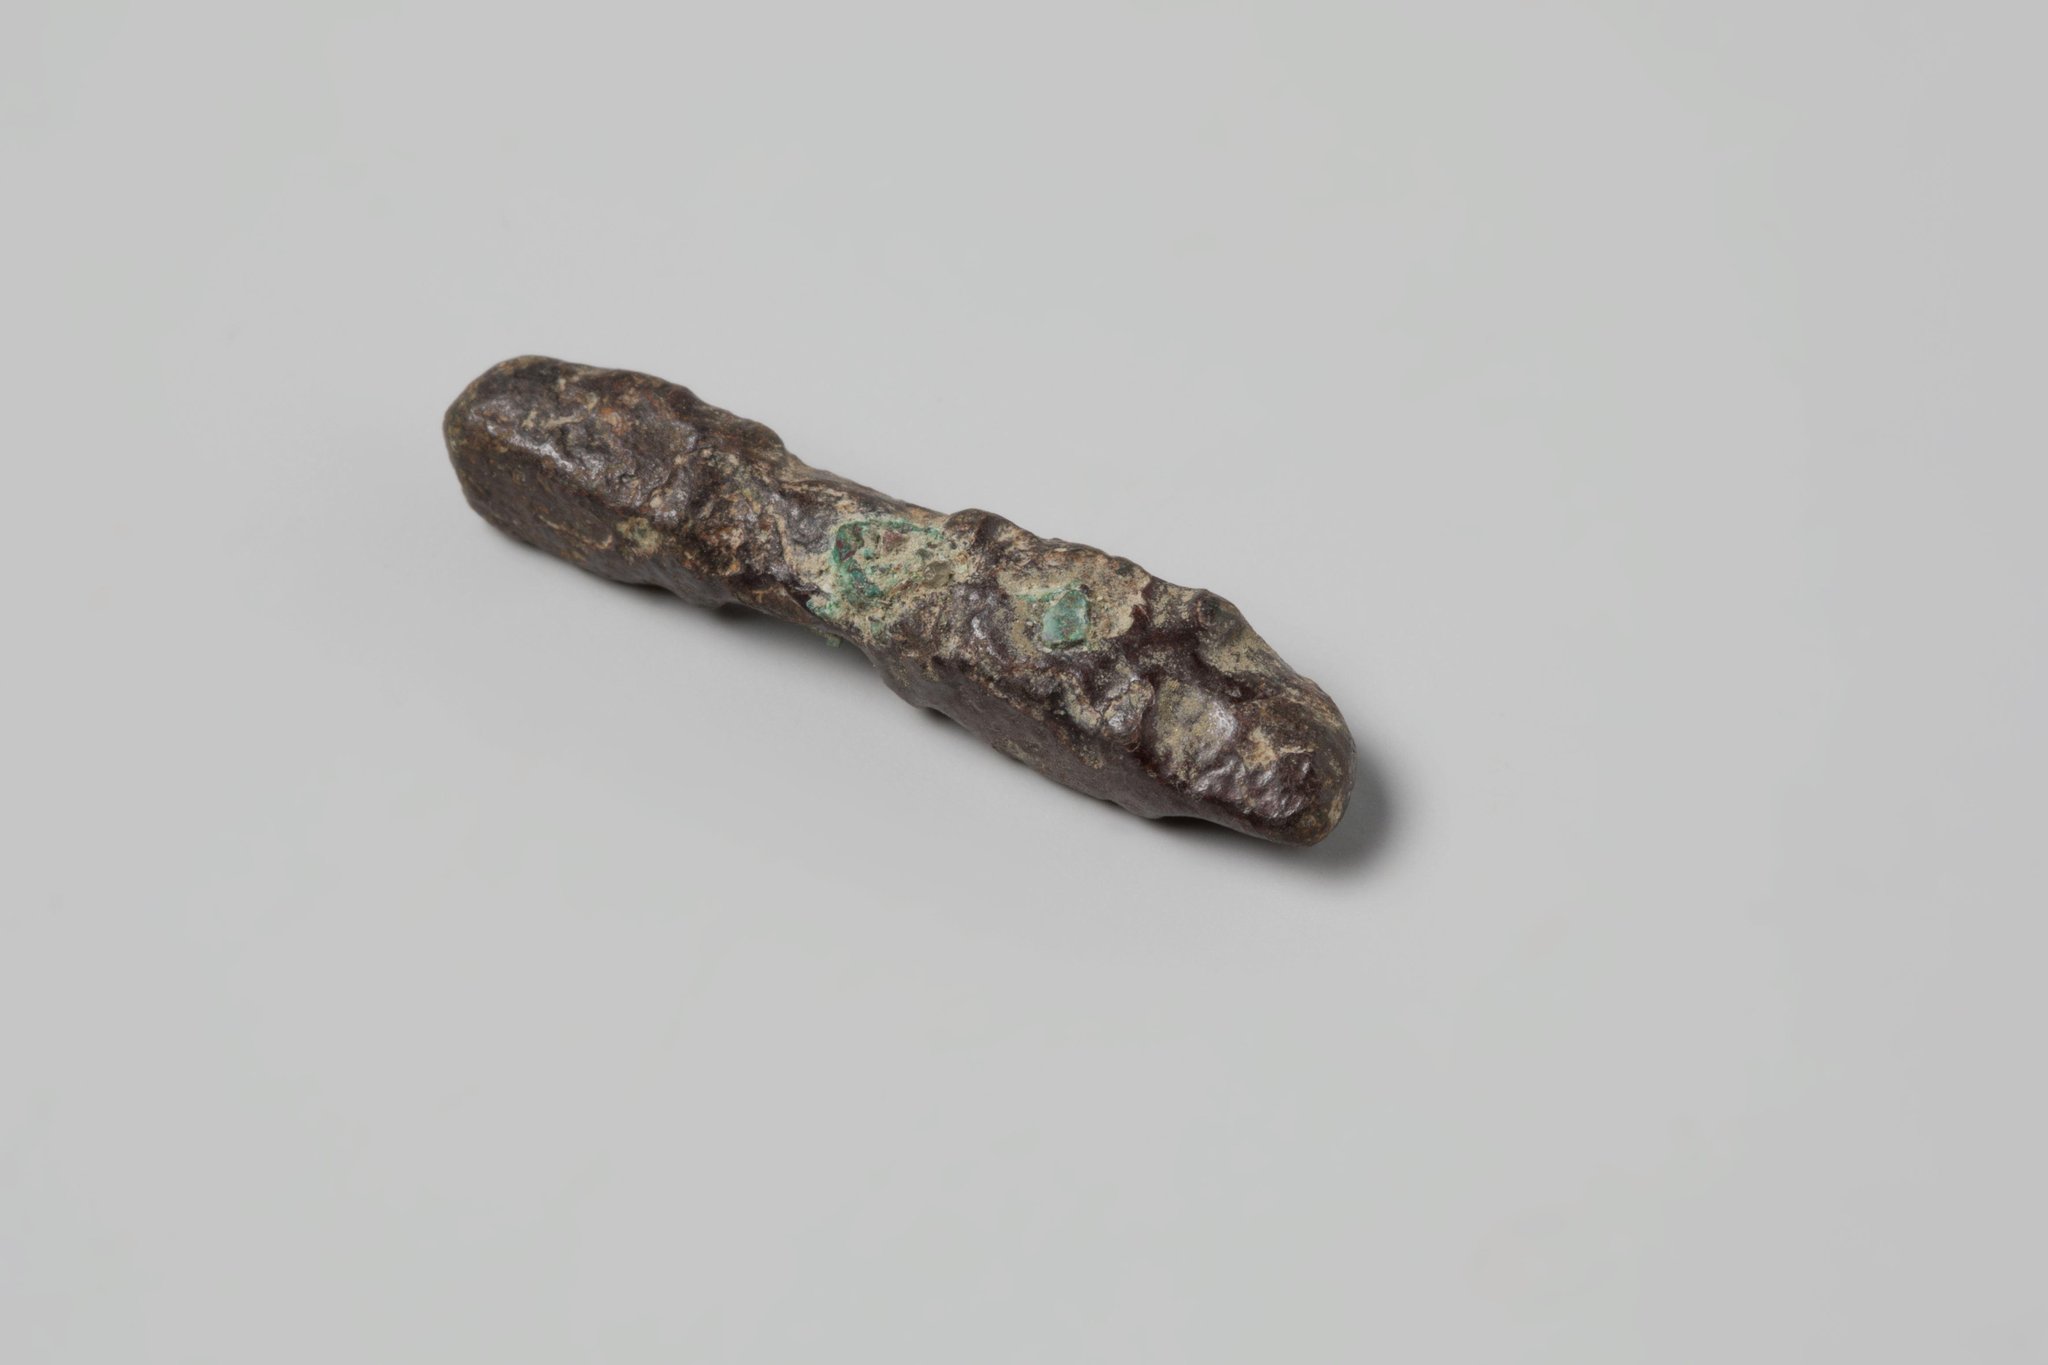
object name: pin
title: Fragment speld uit het wrak van de Oost-Indiëvaarder Hollandia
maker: Anonymous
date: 1700-1743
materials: copper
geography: netherlands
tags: verenigde oostindische compagnie, hollandia (schip), annet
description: Tools and instruments, sewing and sailmaking, pin; fragm of shaft, id. NG 1980-27H3265, eroded.